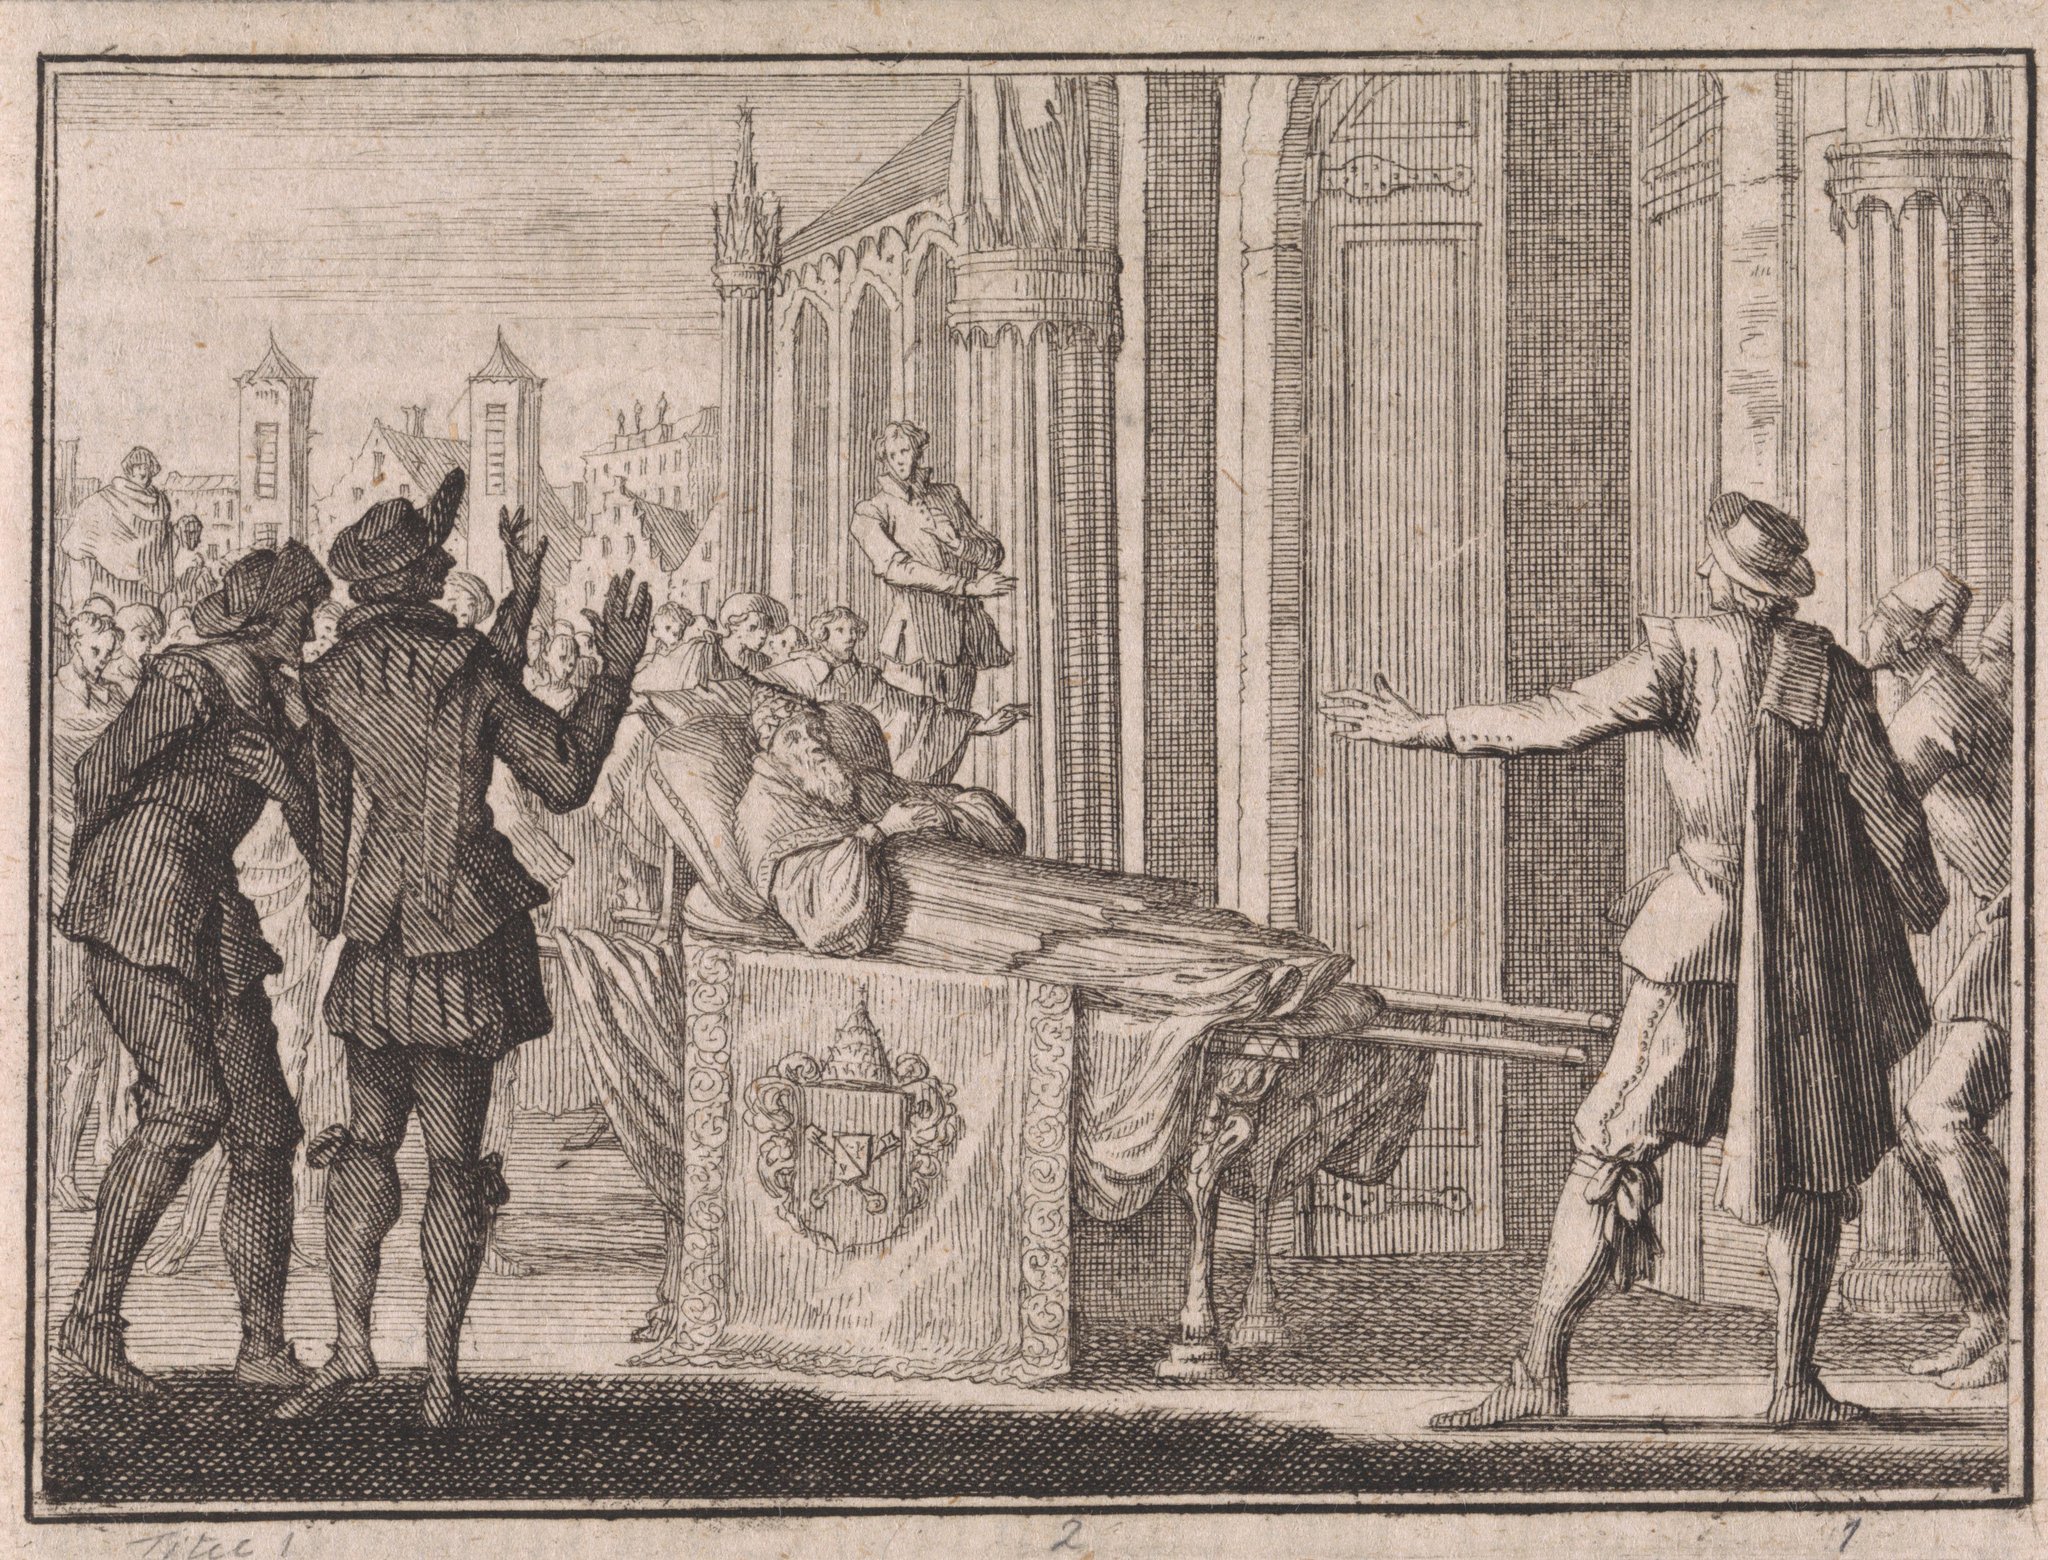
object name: print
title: Schlag drein, es musz seyn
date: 1704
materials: paper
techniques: etching, letterpress printing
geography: nuremberg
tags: cologne, public funeral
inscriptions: collector's mark: Lugt 2228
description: Illustratie uit: Abraham a Sancta Clara. Heilsames Gemisch Gemasch, das ist: Allerley seltsame und verwunderliche Geschichten (...). Neurenberg: Christoph Weigel, 1704, p. 1. (Geregorius VI ligt niet in de St. Pieter te Rome begraven. Maar, het gaat hier wel degelijk om de St. Pieter in Rome, maar niet als kerk waar Gregorius VI begraven is, maar als illustratie bij een van de verhalen die over hem de ronde deden.)